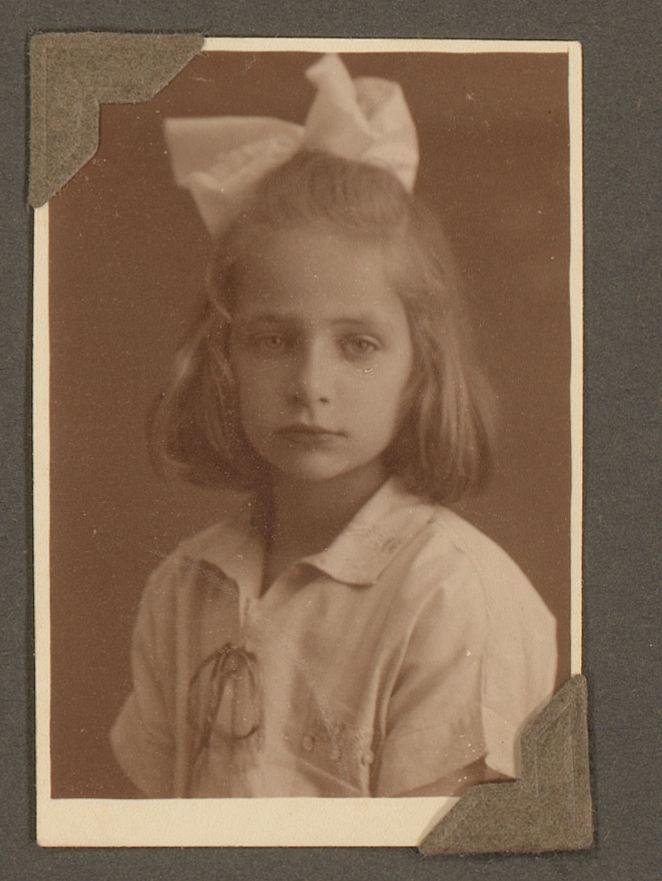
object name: album leaf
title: Portret van een meisje met strik in het haar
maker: Anonymous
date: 1920-1930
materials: photographic support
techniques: matte daylight collodion silver print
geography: netherlands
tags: historical persons, girl (child between toddler and youth)